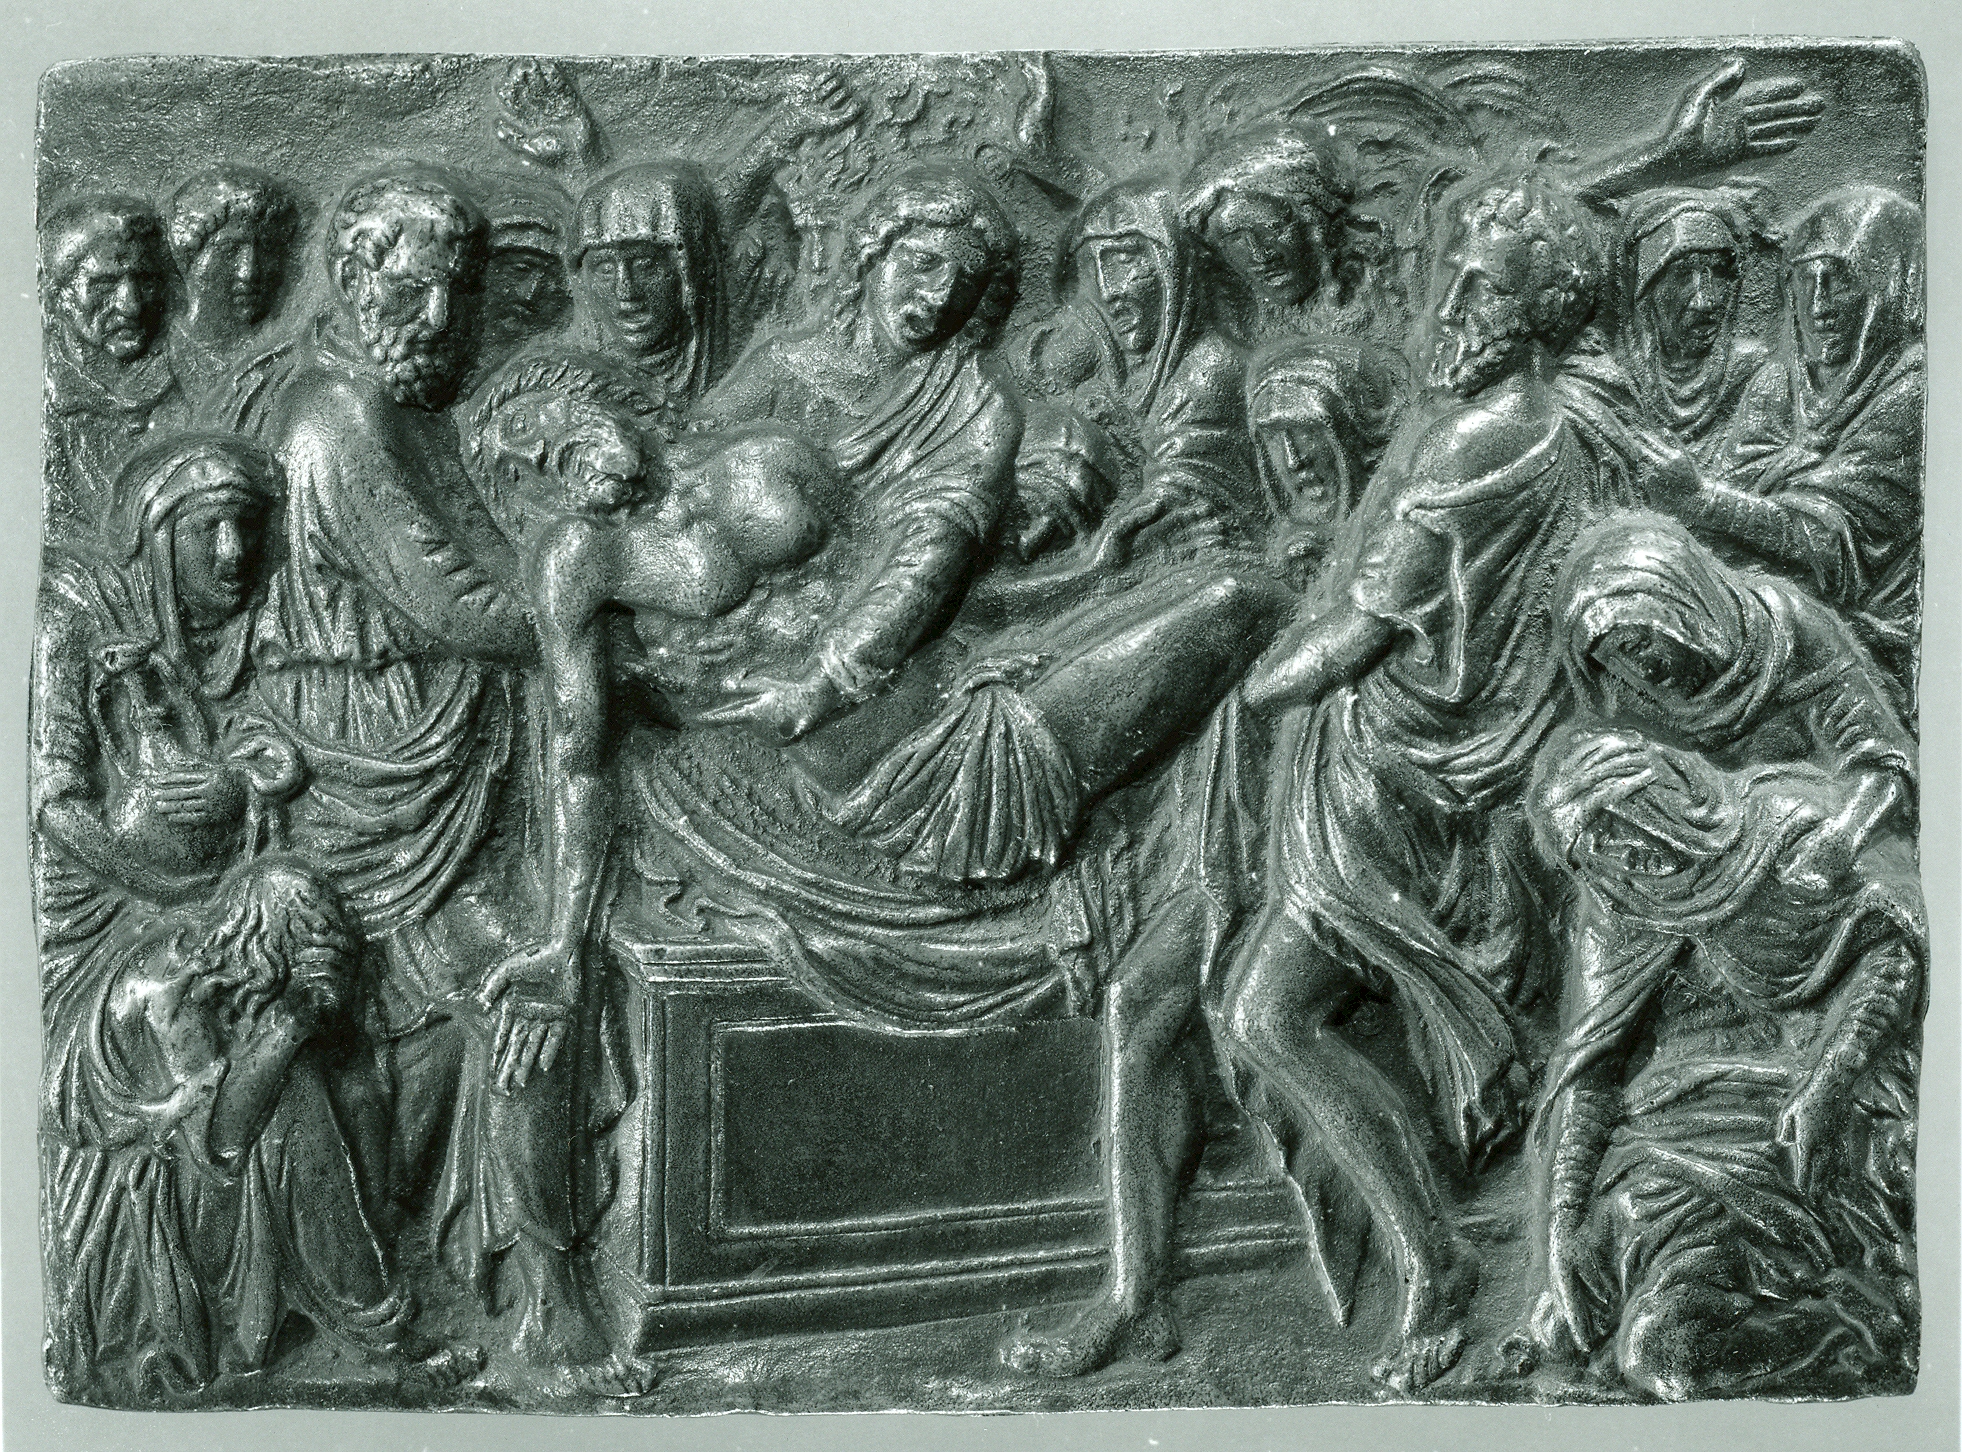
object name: plaquette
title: Entombment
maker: andrea briosco, called riccio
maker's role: artist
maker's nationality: italian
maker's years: 1470-1532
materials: copper alloy, patina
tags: christ,virgin mary,entombment